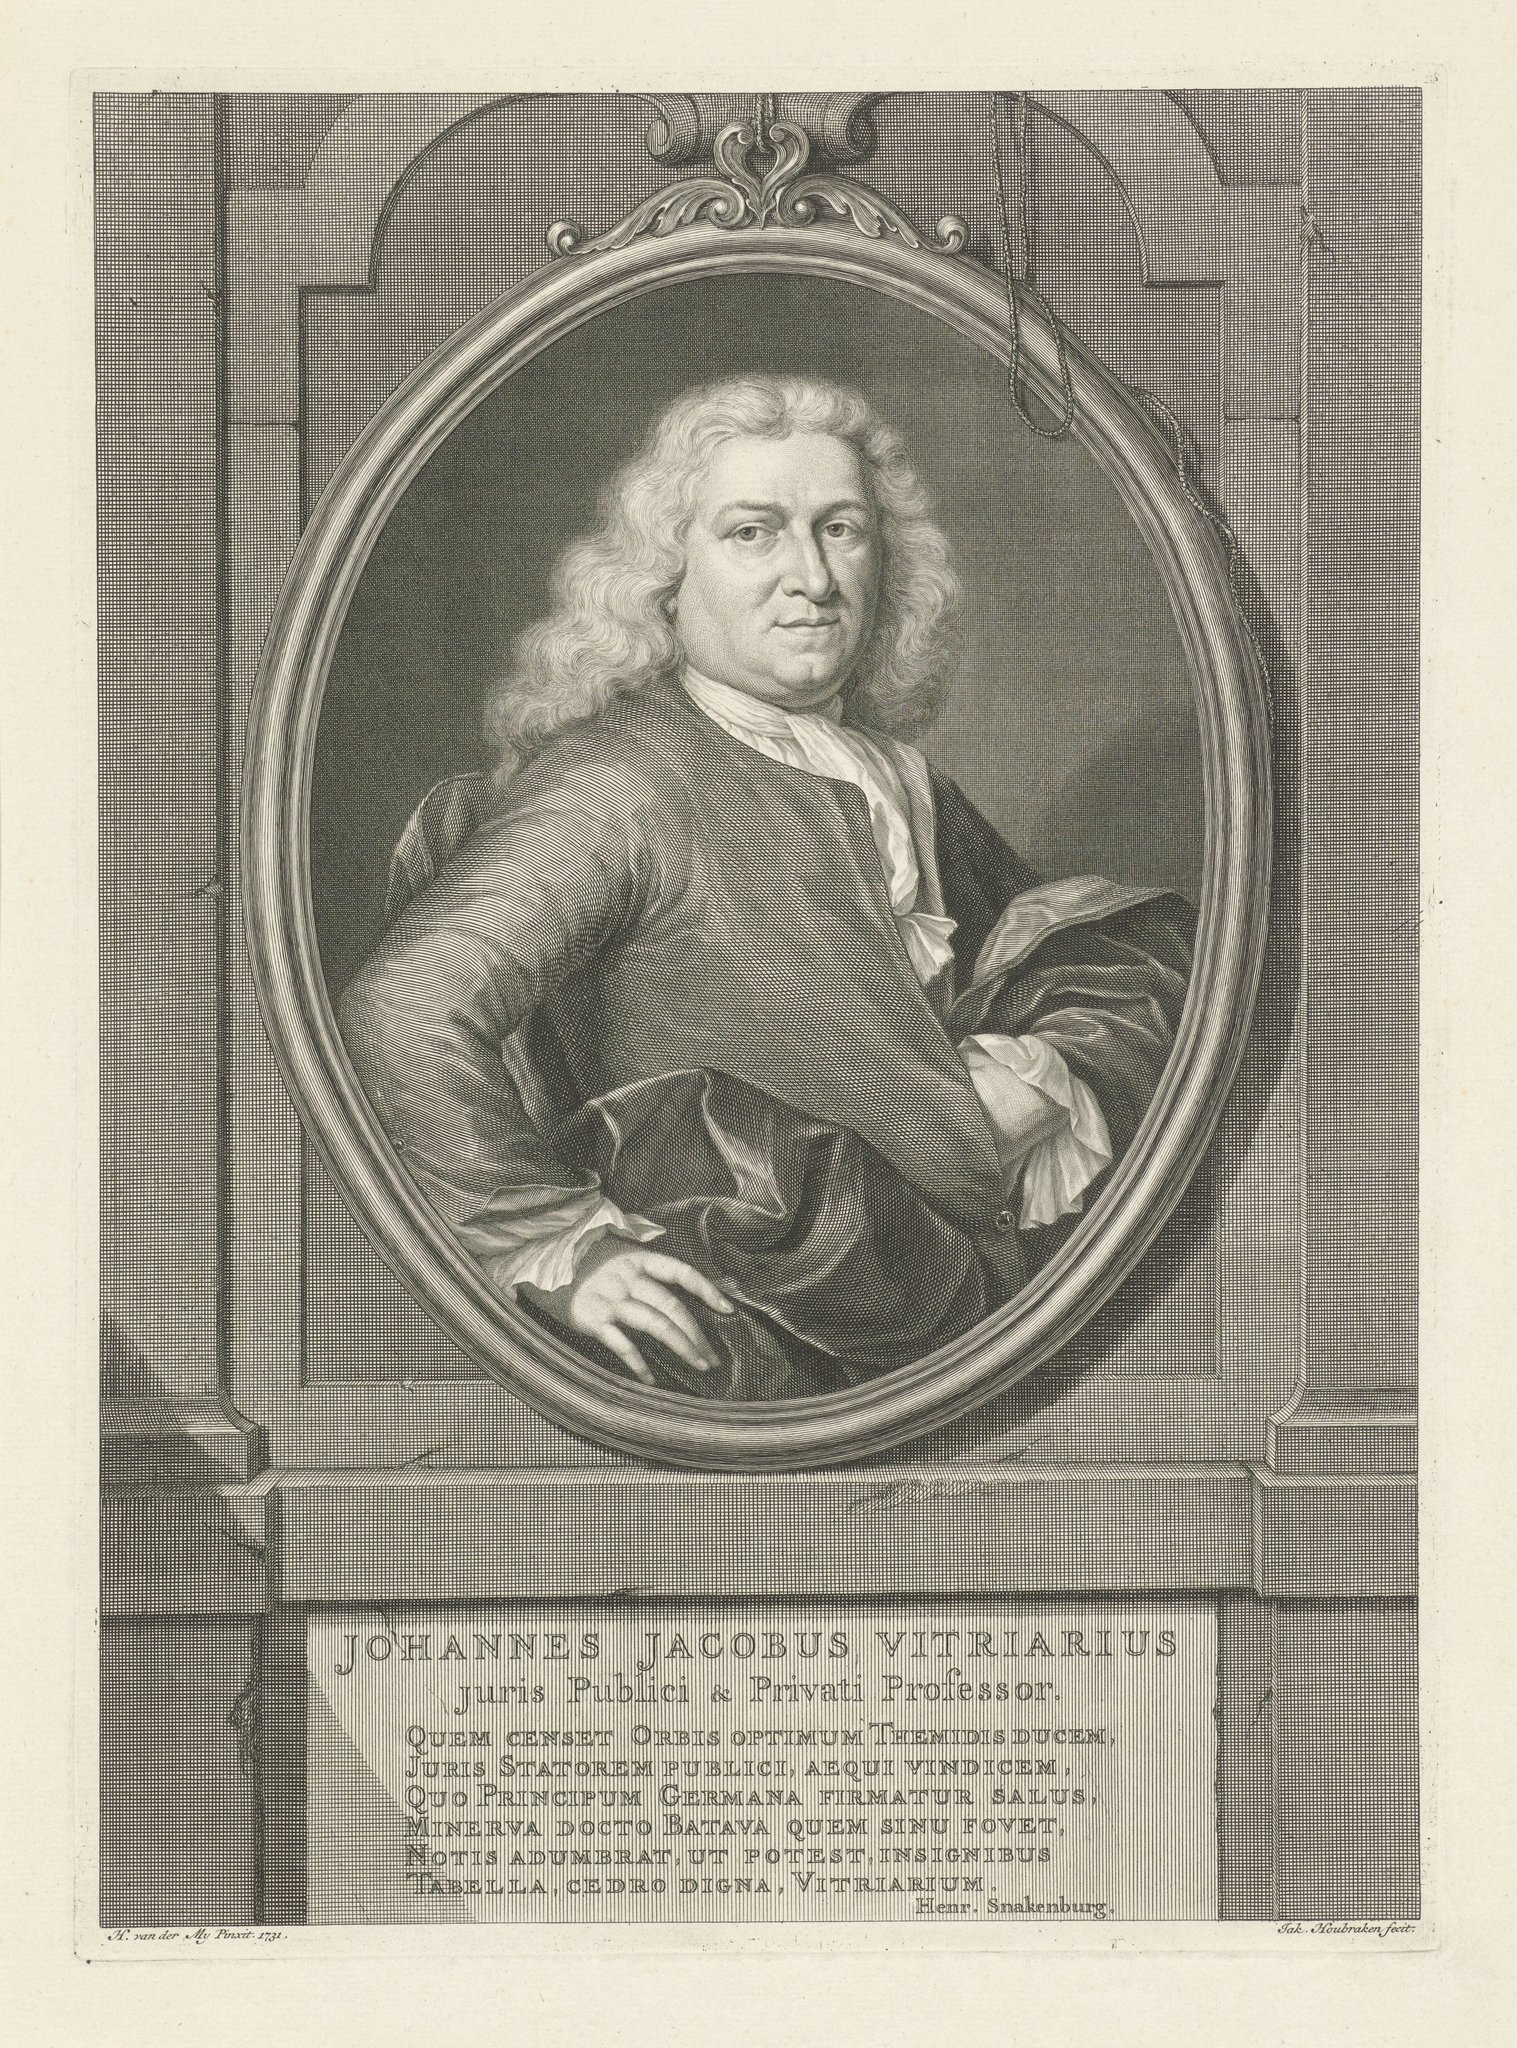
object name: print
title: Johannes Jacobus Vitriarius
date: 1731-1780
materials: paper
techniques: engraving, etching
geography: amsterdam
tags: leiden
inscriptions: collector's mark: Lugt 240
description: Portret ten halven lijve naar rechts van Johannes Jacobus Vitriarius in een ovaal medaillon, tegen een architectonische wand en rustend op een richel. Onder het portret een plaquette waarop de naam en gegevens van de geportretteerd in twee regels in het Latijn en een zesregelig vers in het Latijn.